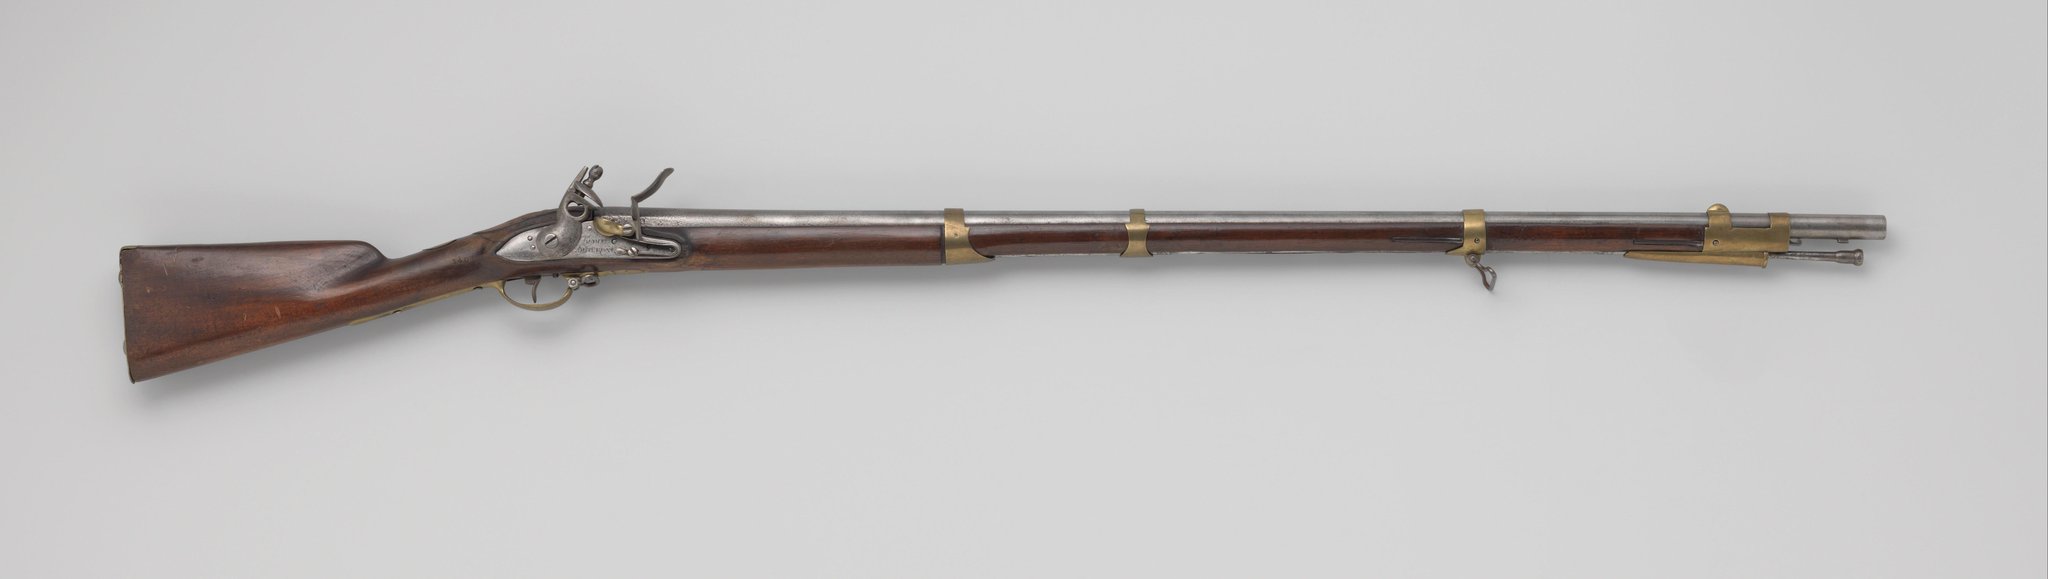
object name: flintlock pistol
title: Vuursteengeweer voor Staatse leger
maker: lambertus michaelis thone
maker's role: weapon manufacturer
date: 1795-1806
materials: brass, steel, wood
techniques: printing, cutting, engraving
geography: amsterdam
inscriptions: inscription: ‘W.L.I.//FUND’, town mark, number: ‘411’, signature: ‘THONE // AMSTERDAM’, number: ‘81403; 1403’